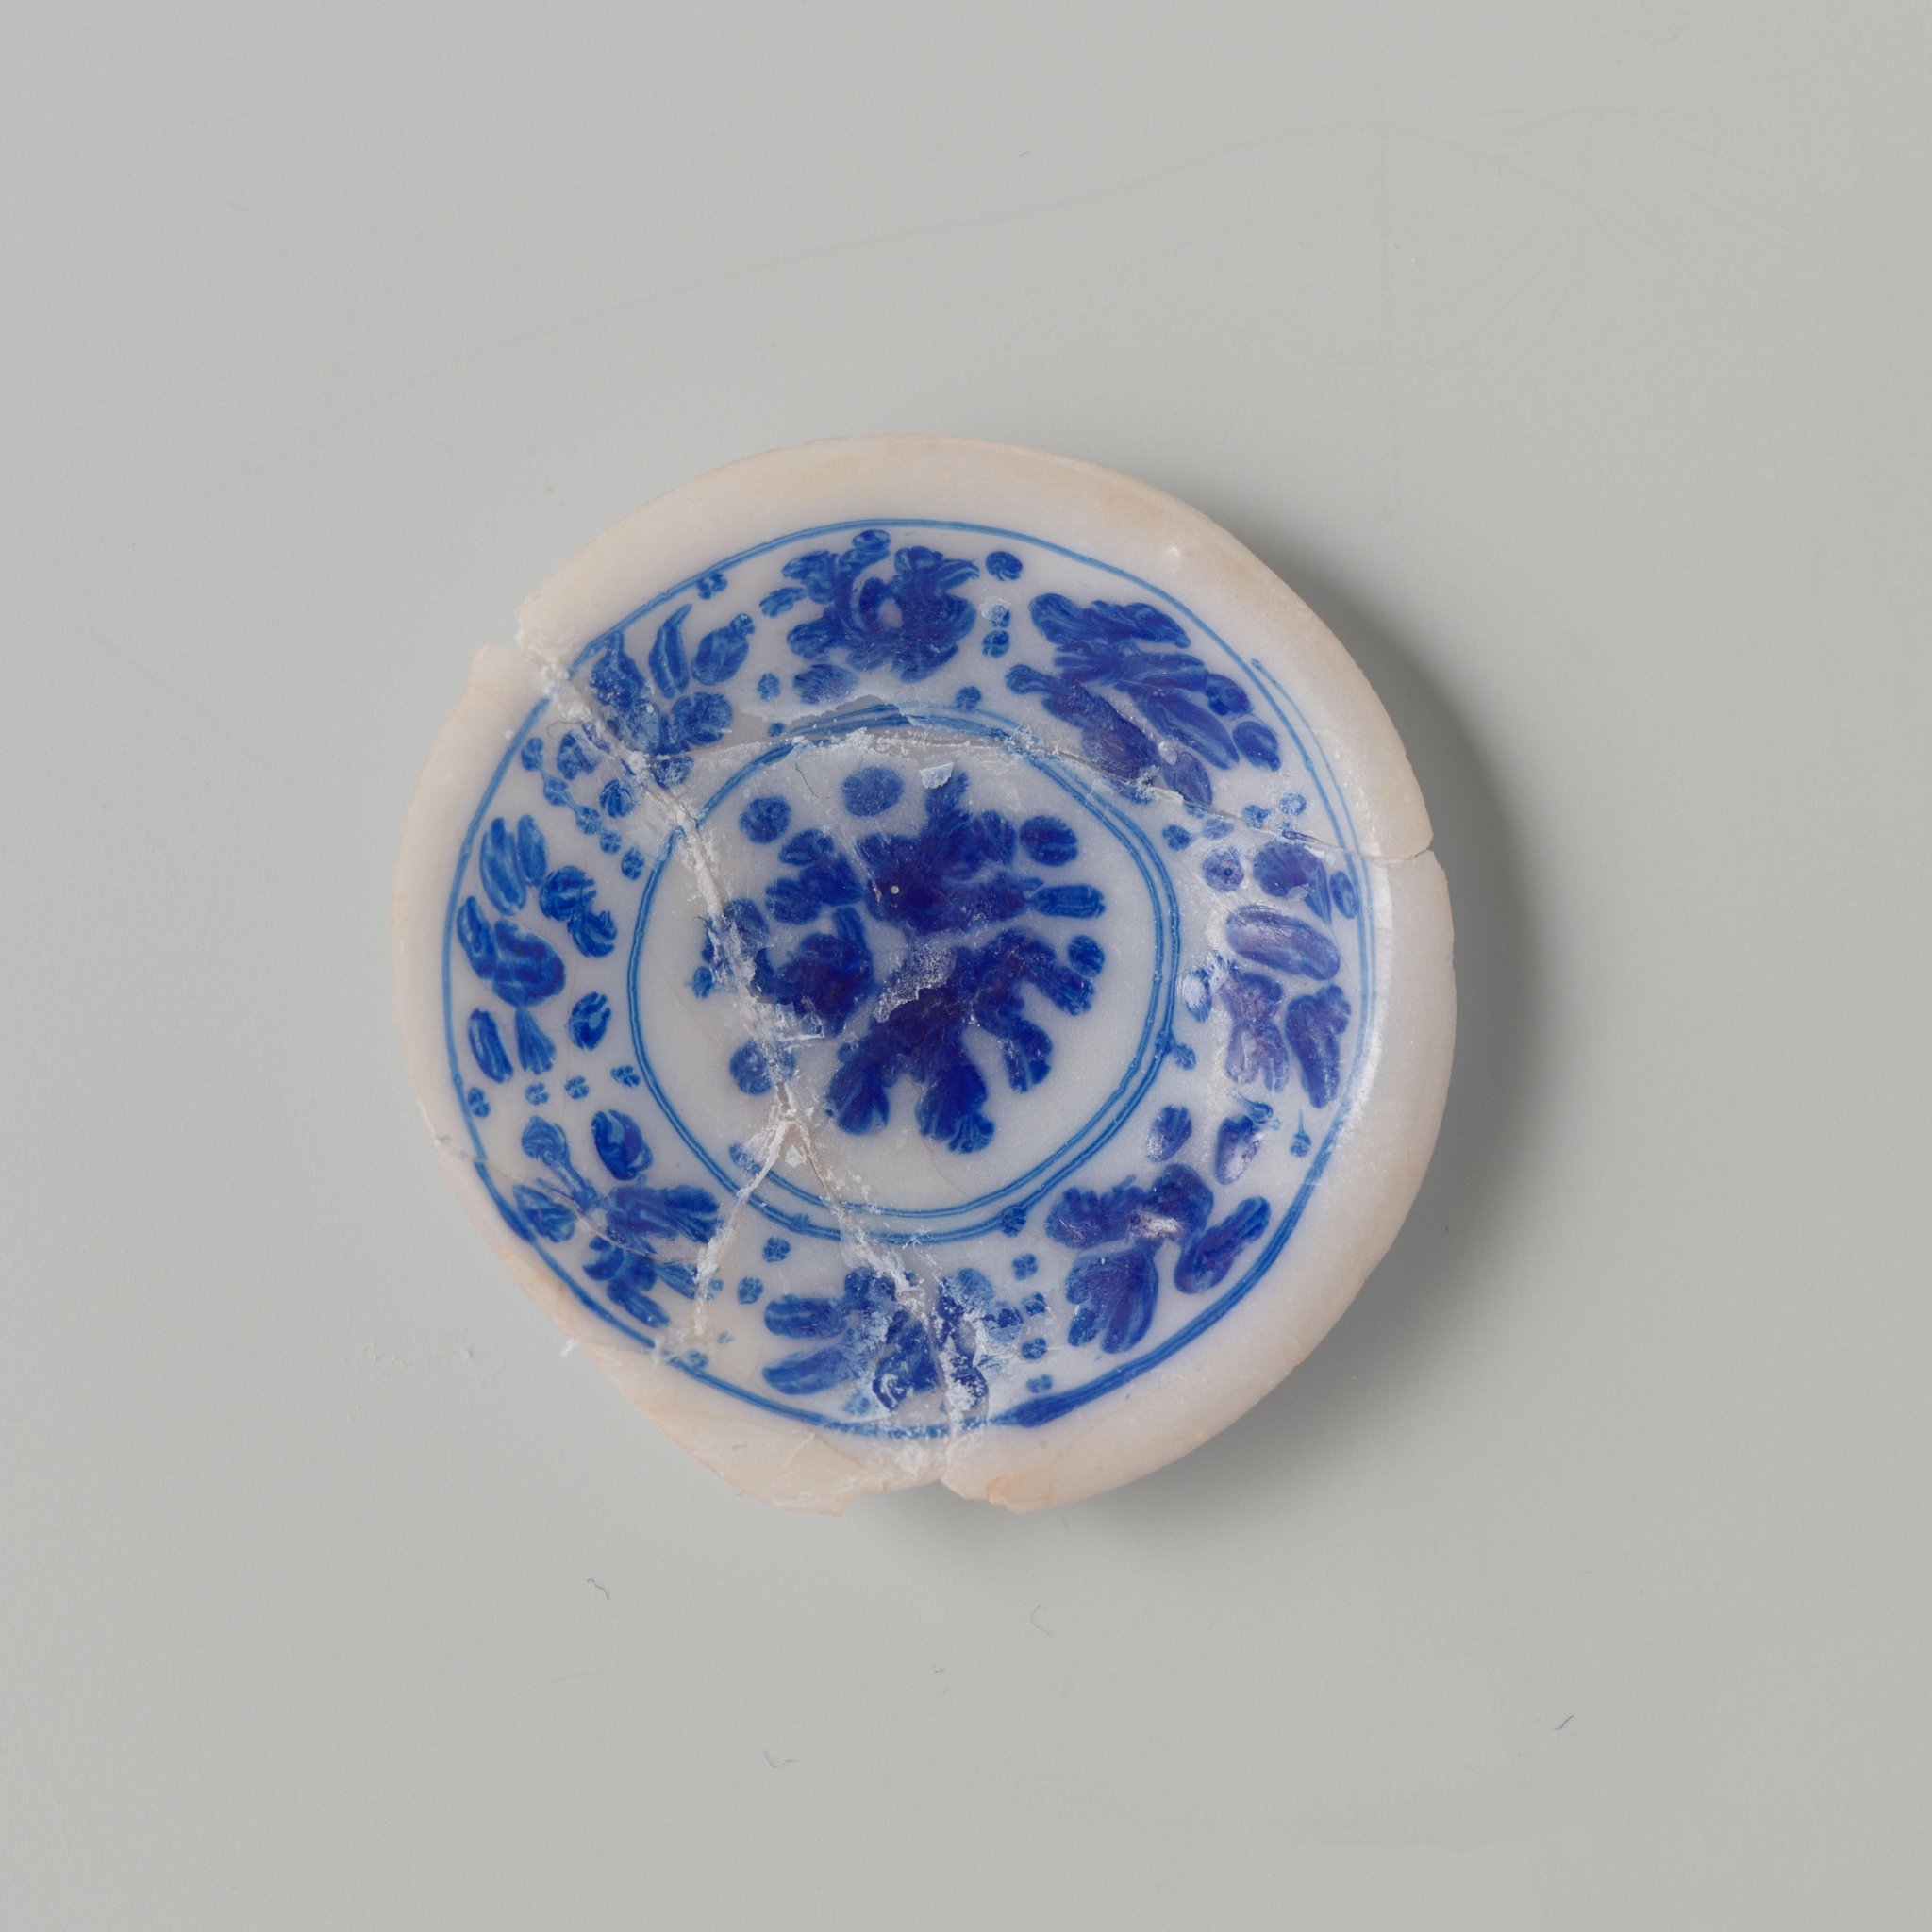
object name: plate dish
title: Schotel van melkglas met blauwe emailverf beschildering, imitatie Chinees porselein; bloemmotieven in vakken in Kraakporselein stijl; dubbelwandig met gladde rand.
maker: Anonymous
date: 1675-1710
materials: glass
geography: amsterdam